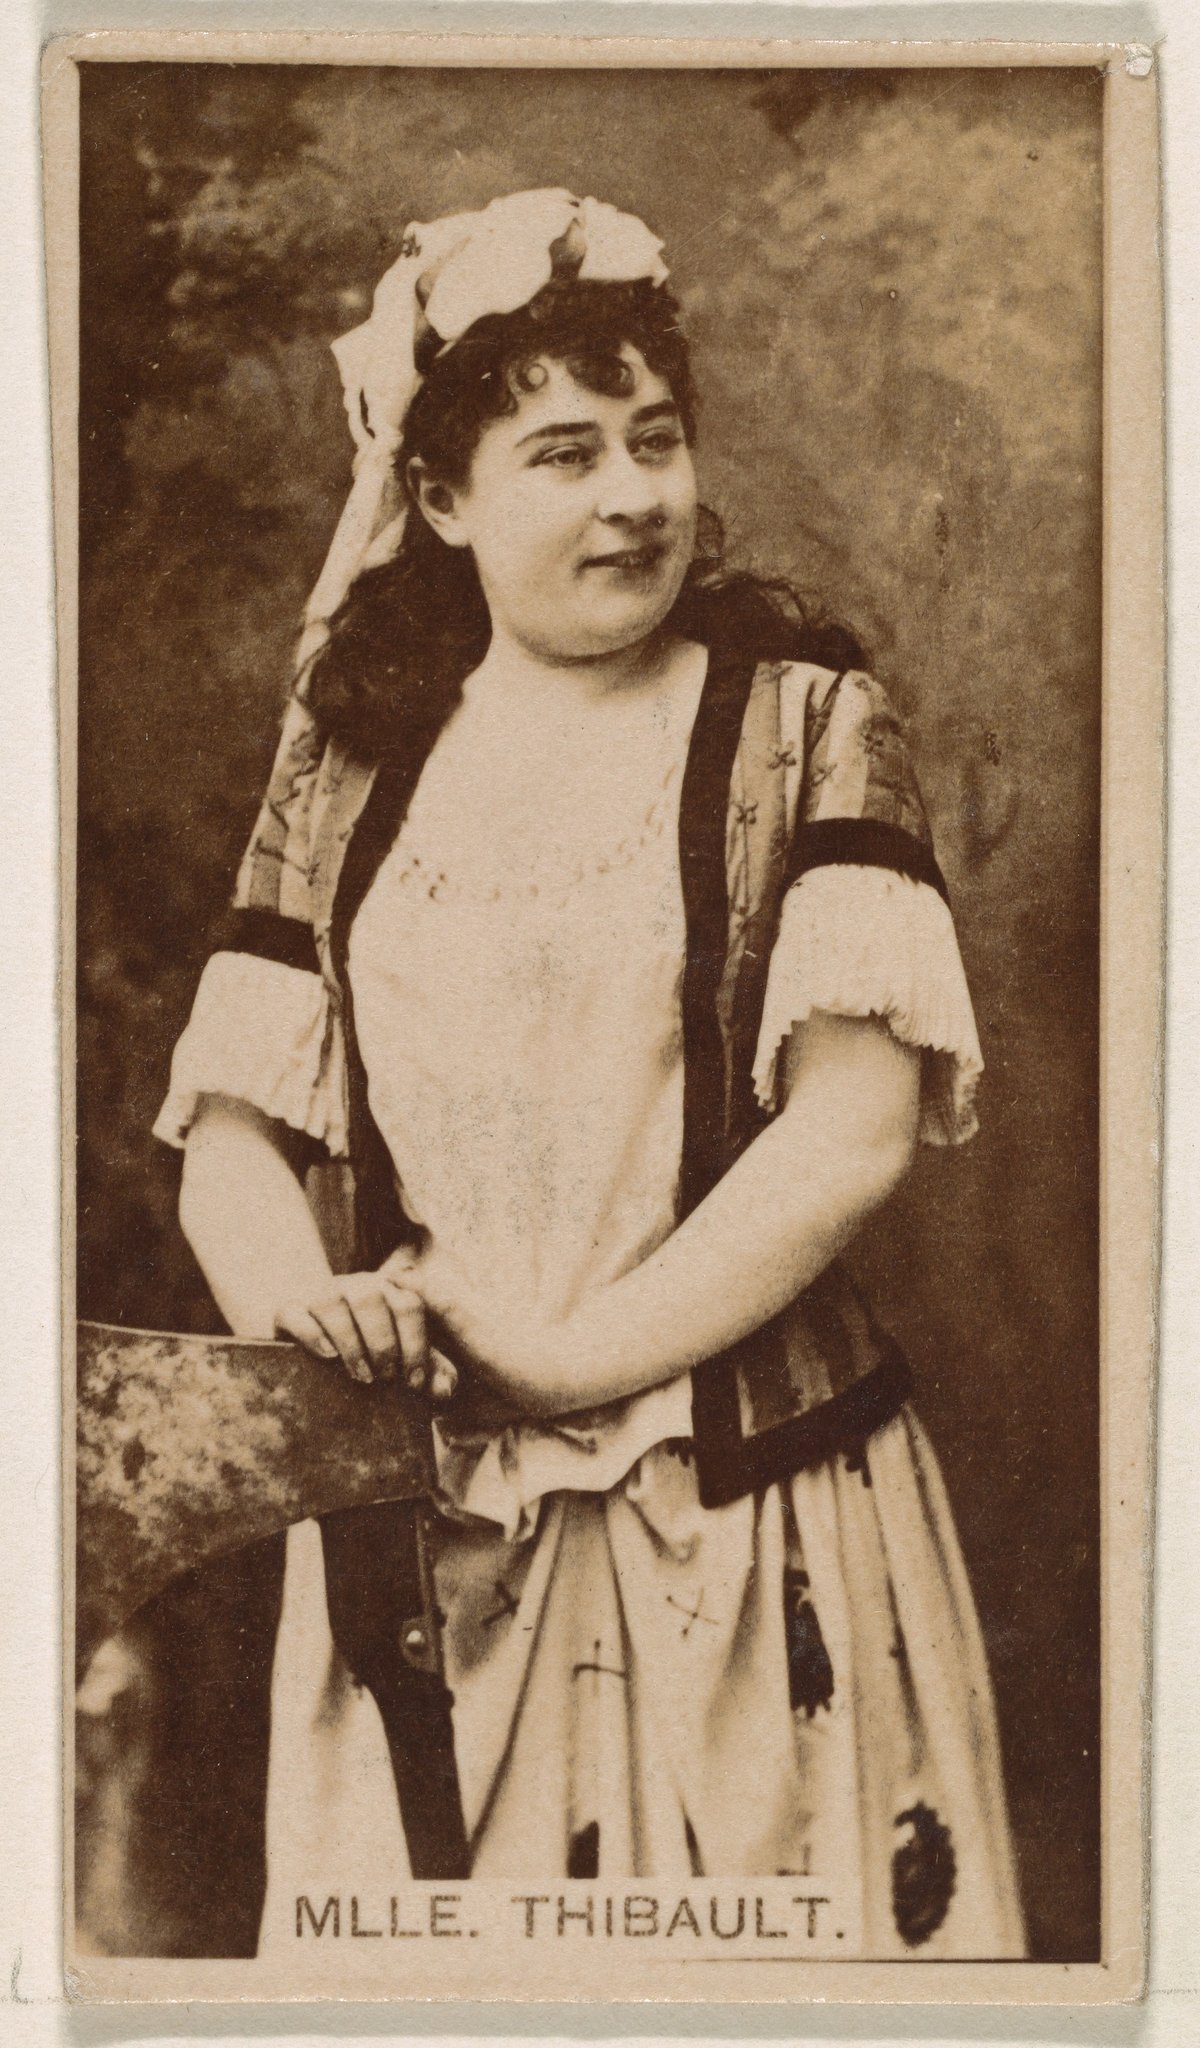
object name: photograph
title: Mlle. Lena Thibaut, from the Actresses series (N245) issued by Kinney Brothers to promote Sweet Caporal Cigarettes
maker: kinney brothers tobacco company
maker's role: publisher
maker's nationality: american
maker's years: 1869-2011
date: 1890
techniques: albumen silver print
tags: portraits,women,actresses